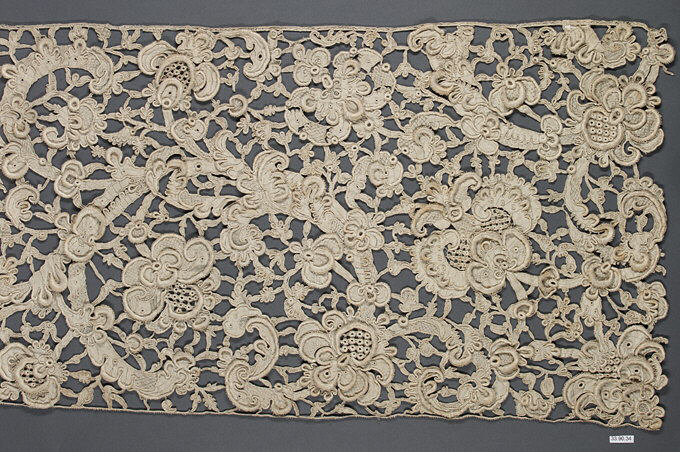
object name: border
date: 1601-1700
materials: lace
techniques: gros point, lace